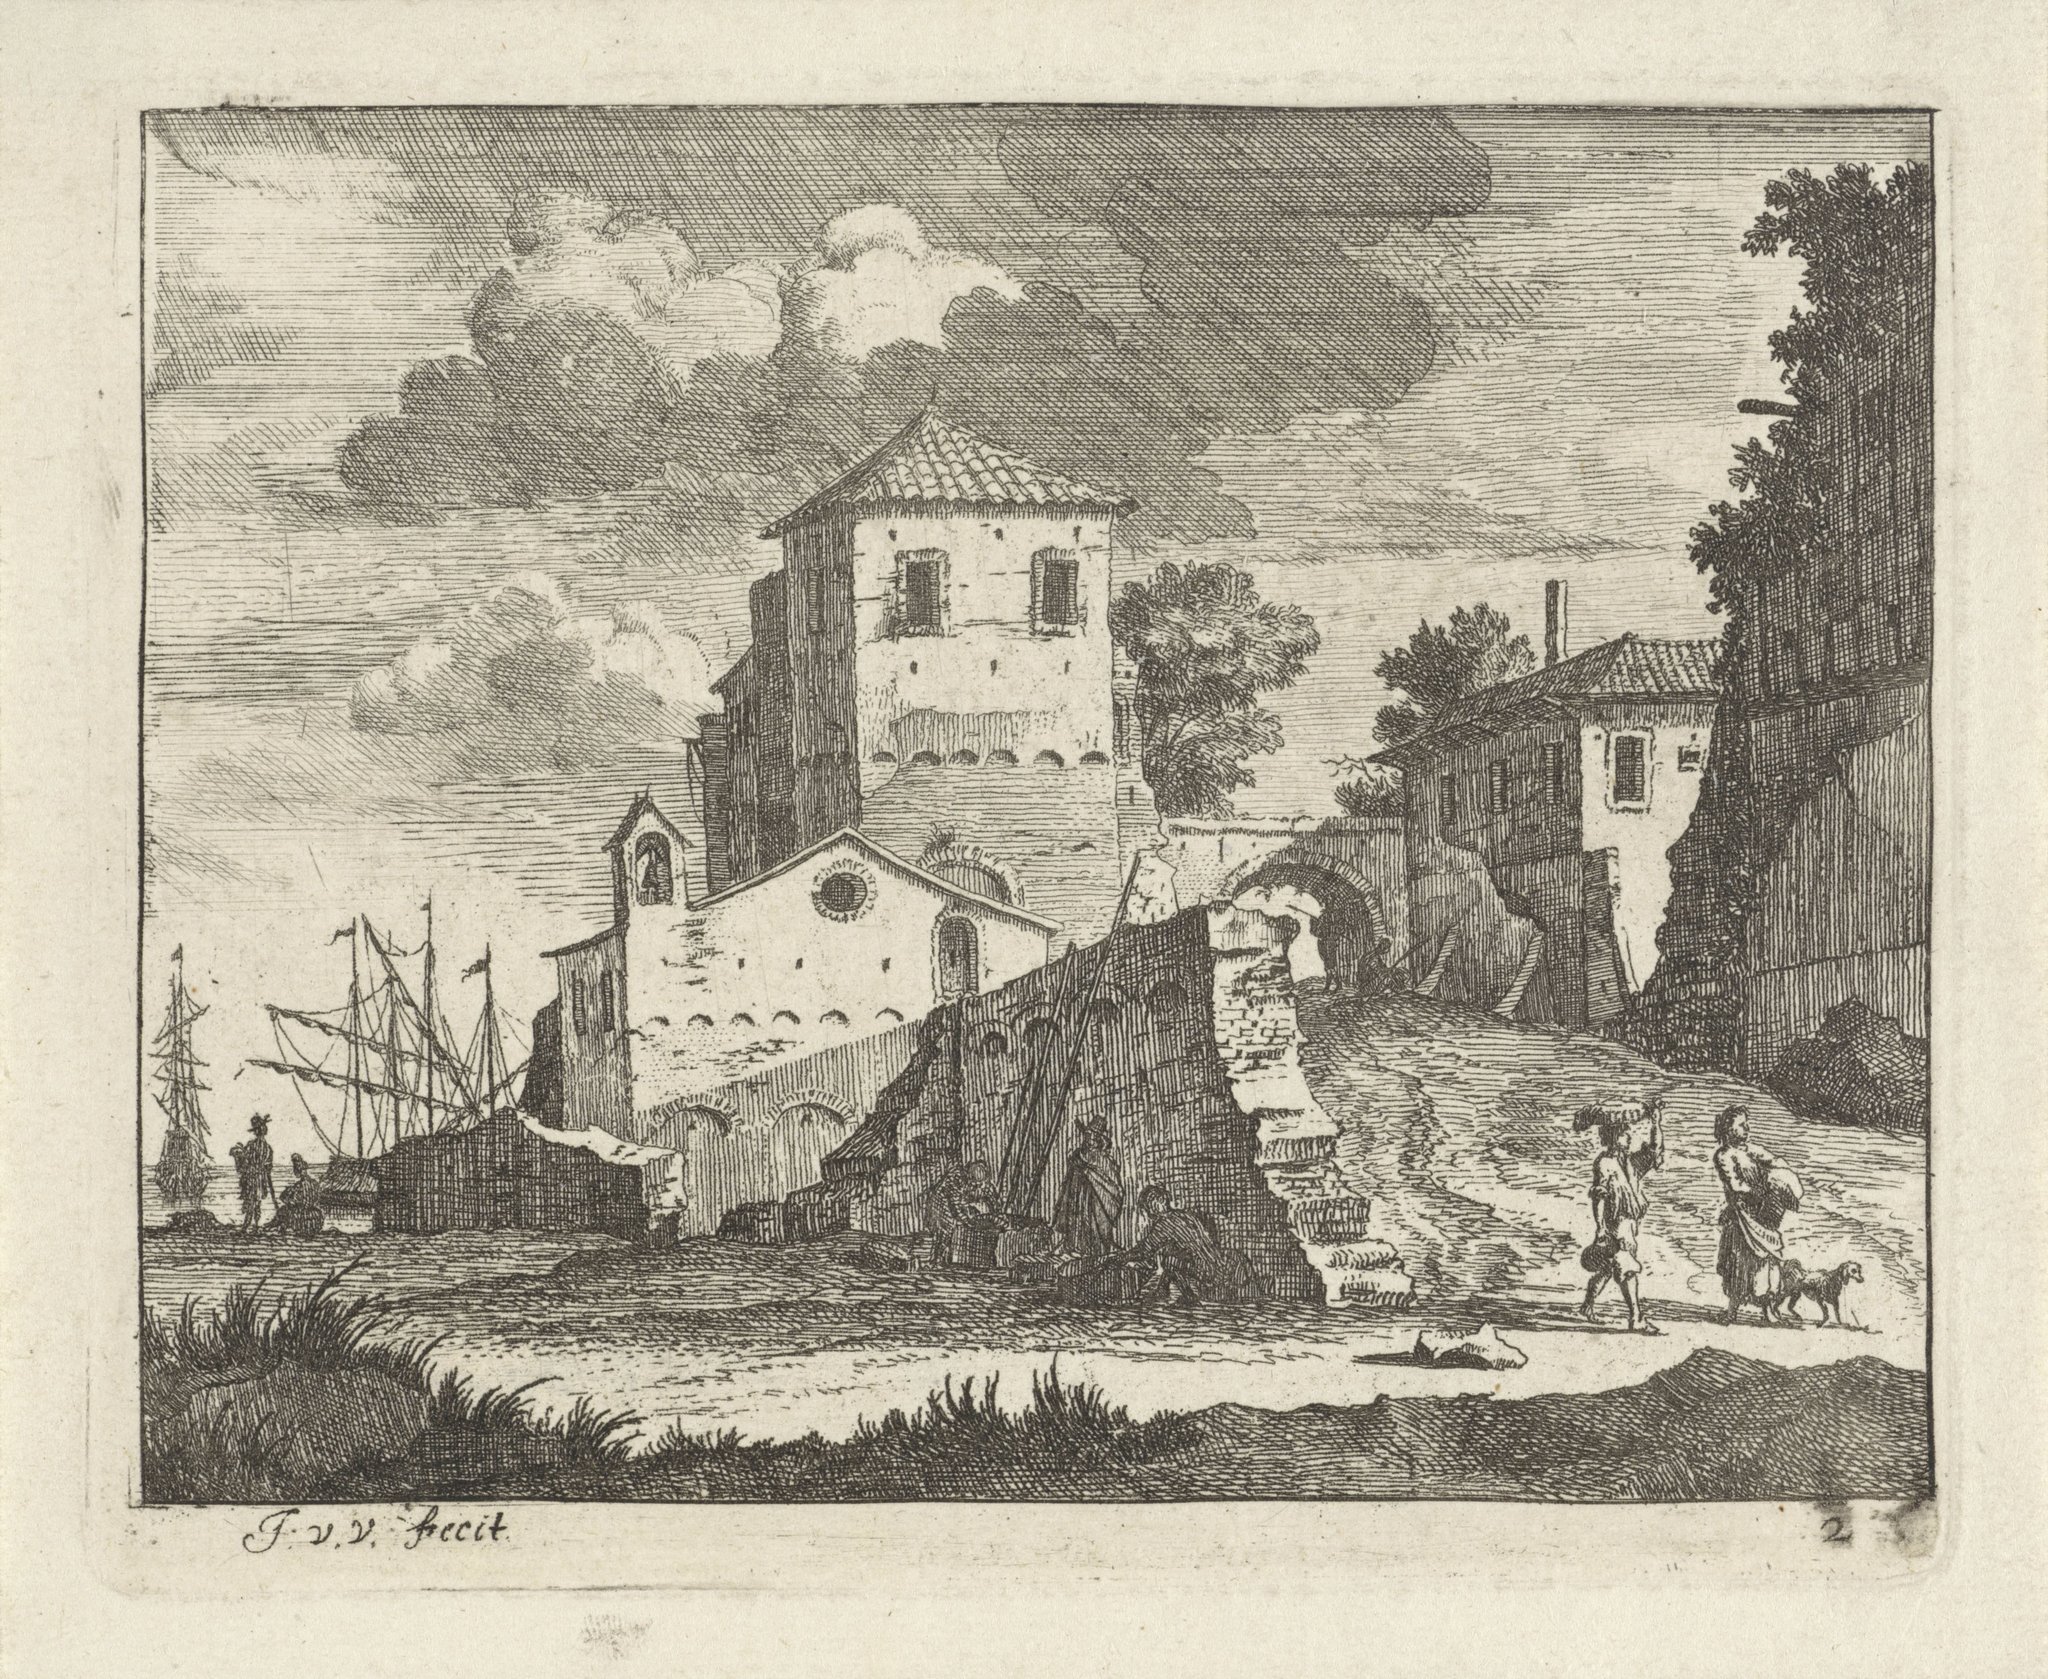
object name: print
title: Italiaanse havenplaatsen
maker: thomas wijck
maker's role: draughtsman, painter, print maker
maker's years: 1616-1677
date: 1686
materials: paper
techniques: etching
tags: harbour, towers ~ fortified city, city-walls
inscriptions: collector's mark: Lugt 2228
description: Gezicht op een havenplaats. Twee figuren met een hond en waar op de voorgrond. Op de achtergrond masten van boten.